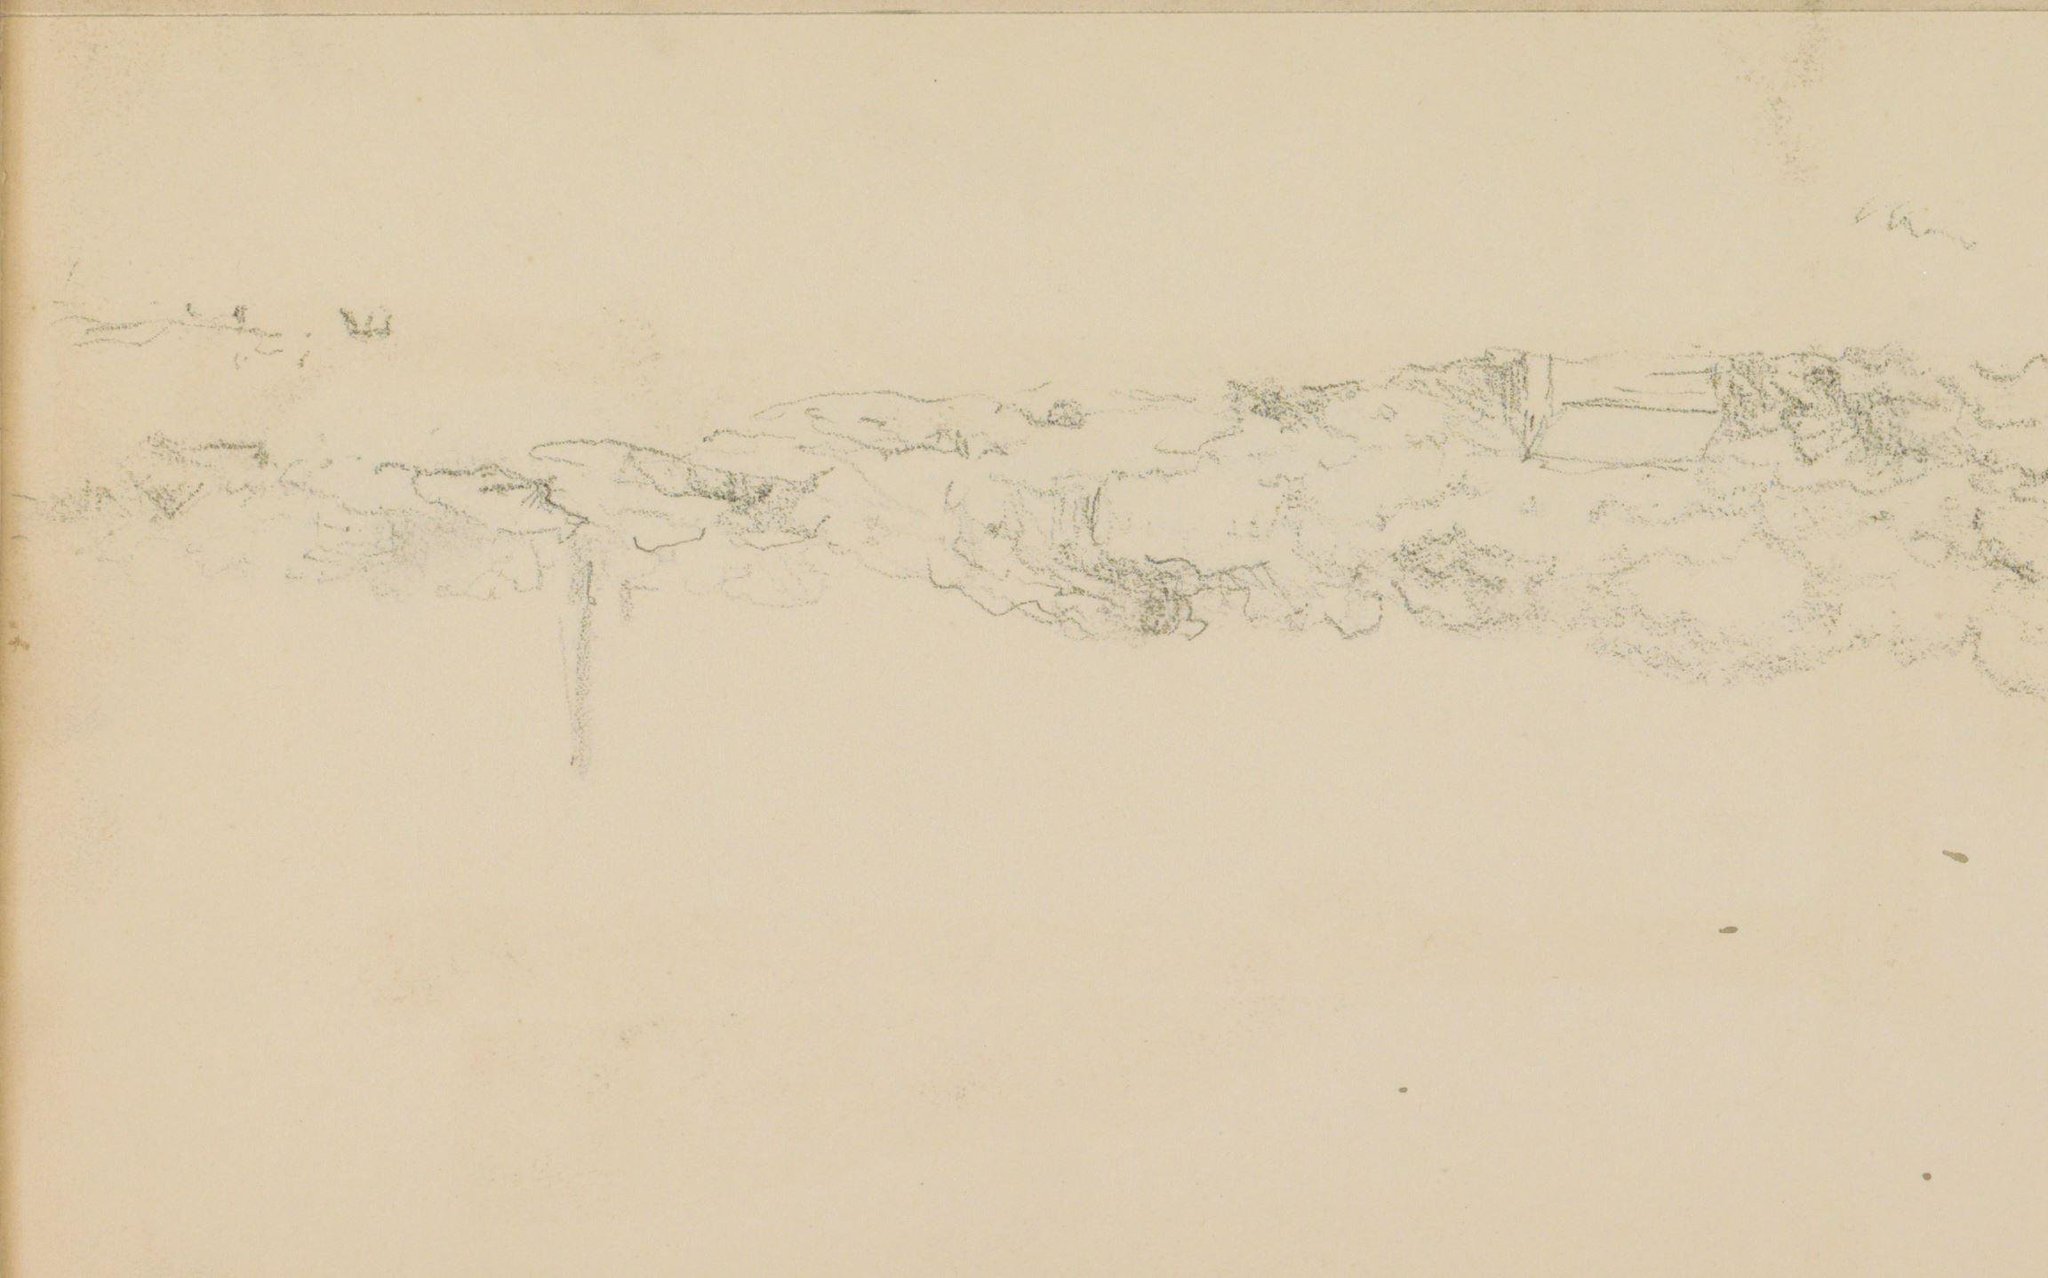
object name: sketchbook leaf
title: Landschap met bomen en een stadsgezicht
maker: a.a.l. de grammont-hubrecht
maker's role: draughtsman, painter, print maker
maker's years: 1855-1913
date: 1892-1913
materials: chalk, paper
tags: city-view, and landscape with man-made constructions, trees, church (exterior)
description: Blad 27 verso uit een schetsboek met 31 bladen.